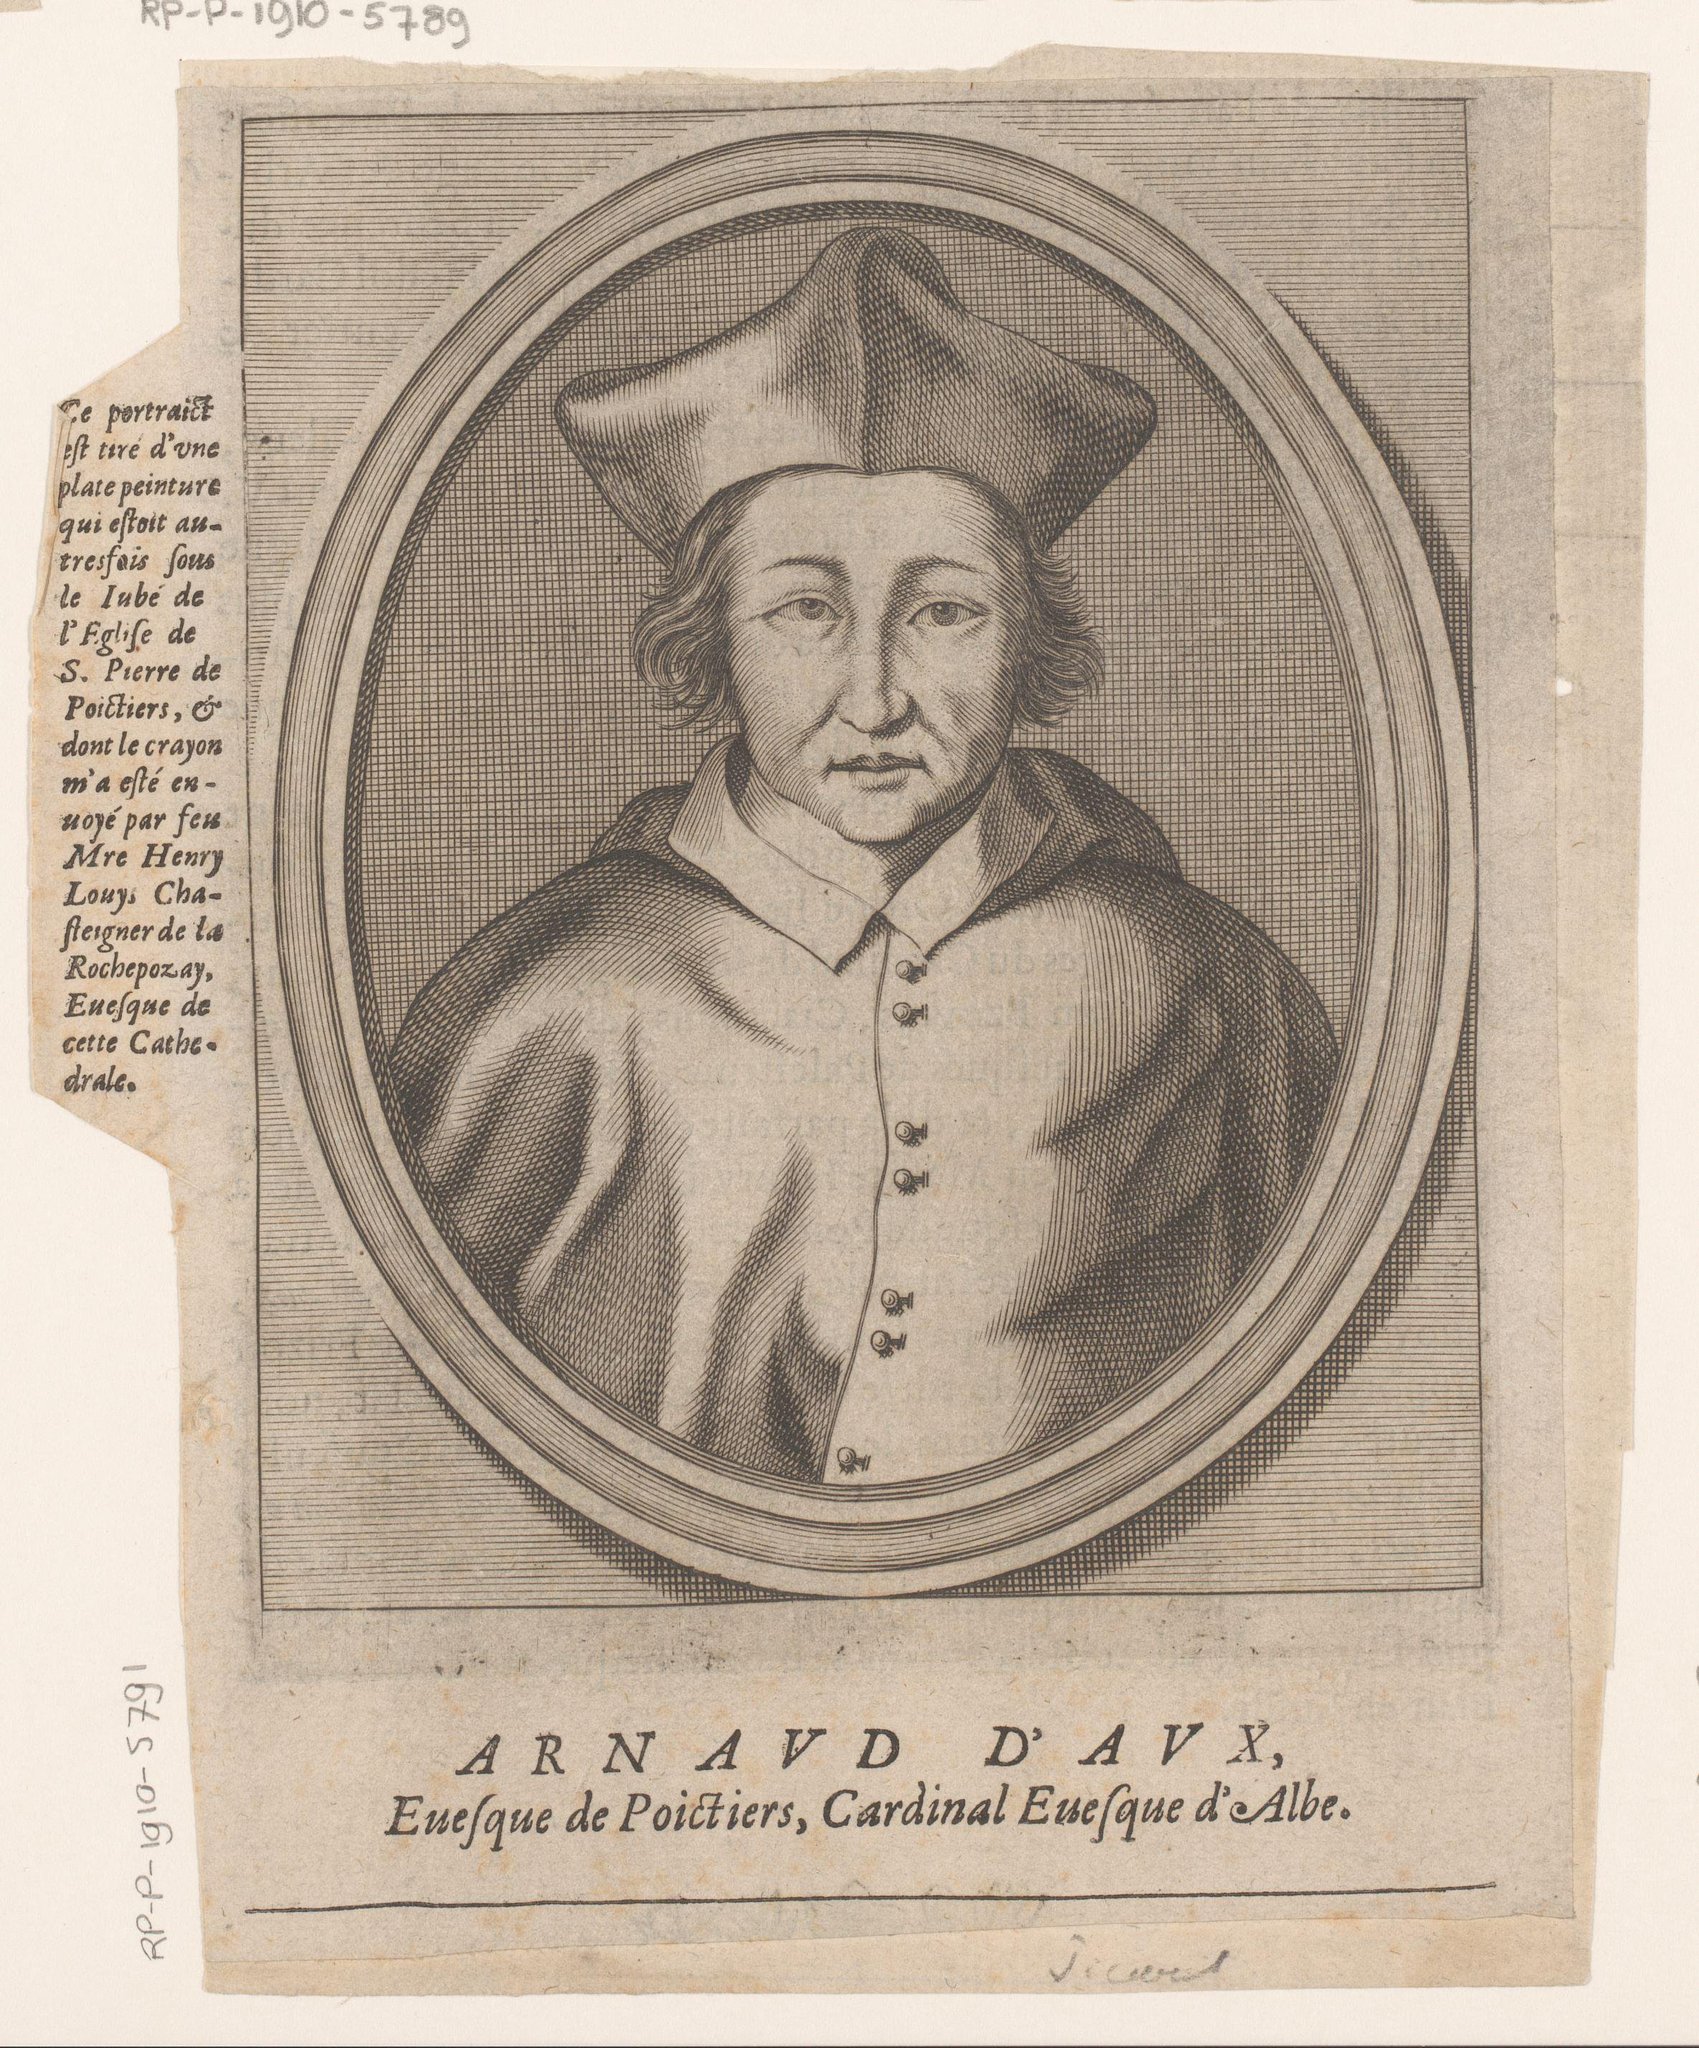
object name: book illustration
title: Portret van Arnaud d'Aux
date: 1660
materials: paper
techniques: engraving, etching, letterpress printing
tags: archbishop, bishop, etc. (roman catholic), historical persons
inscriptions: collector's mark: Lugt 2228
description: Prent uit: Du Chesne, François. Histoire de tous les cardinaux françois de naissance, ou qui ont esté promeus au cardinalat. Parijs: François Du Chesne, 1660.